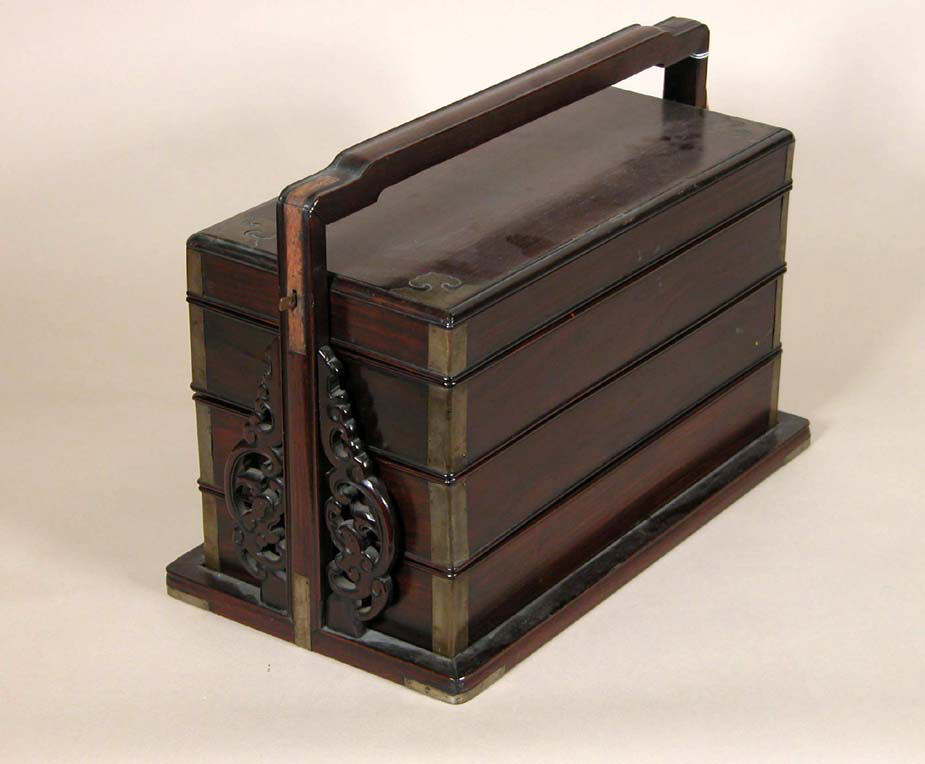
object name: box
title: Boxes with Tray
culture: chinese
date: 1801-1900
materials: brass